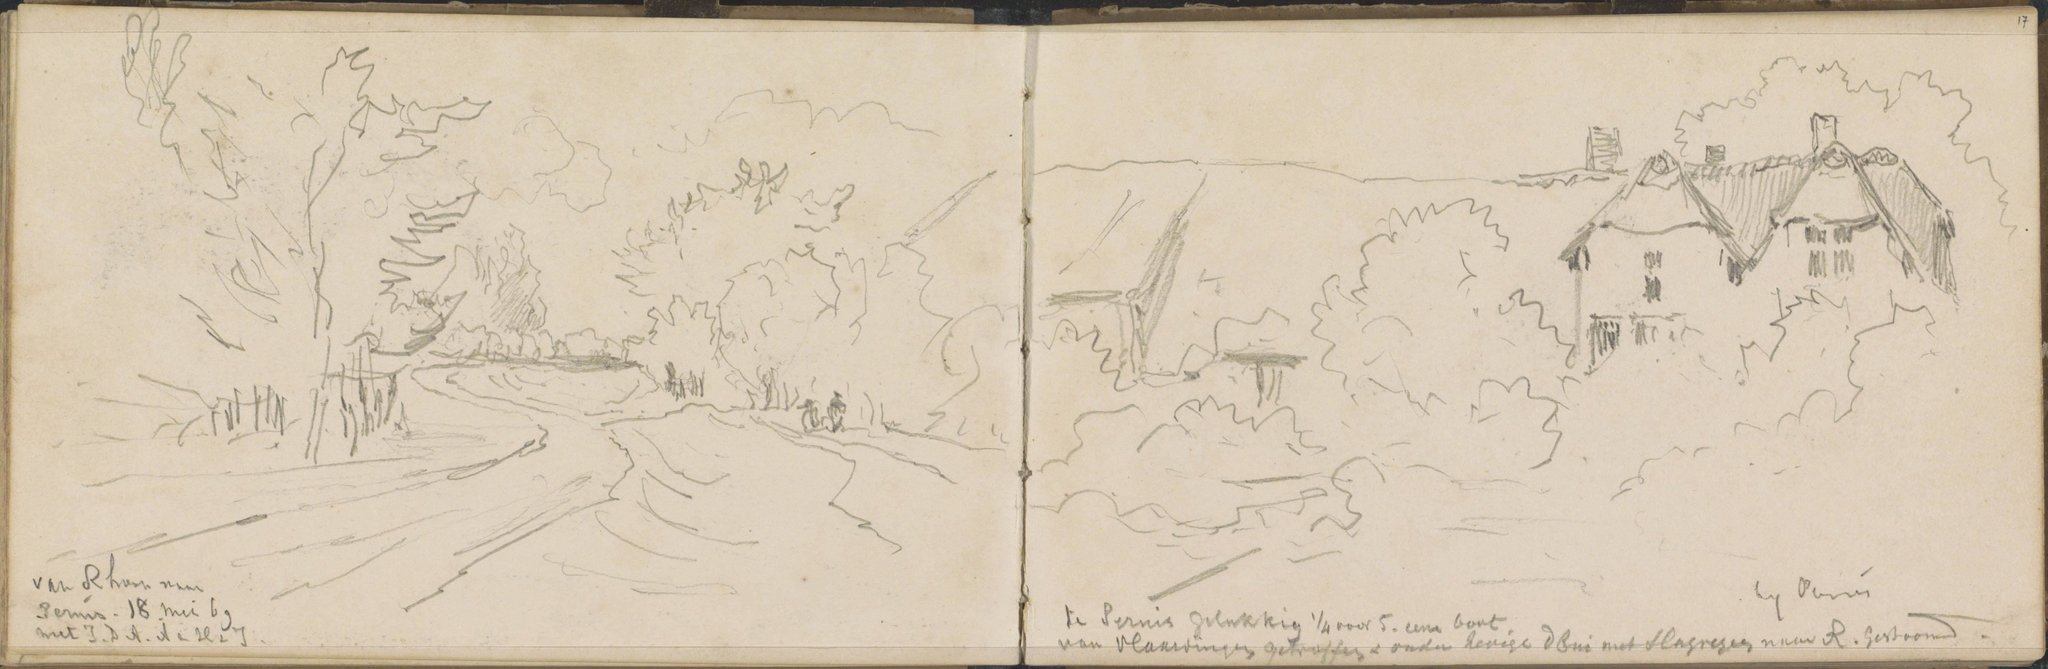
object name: sketchbook leaf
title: Huizen aan de weg van Rhoon naar Pernis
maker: johannes tavenraat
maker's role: draughtsman, painter, print maker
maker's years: 1809-1881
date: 1805-1869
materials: paper, pencil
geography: pernis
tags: city-view, and landscape with man-made constructions, rural housing, e.g. country-house, villa, cottage, road, path, rhoon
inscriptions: date and inscription: ‘van Rhoon naar/ Pernis. 18 mei 69/ met J.D.A. [...] & H & J/ bij Pernis/ te Pernis gelukkig 1/4 voor 5 uur eene boot/ van Vlaardingen getroffen & onder hevige [...]bui met slagregen naar R. gestoomd.’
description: Blad 16 verso en 17 recto uit een schetsboek met 48 bladen.